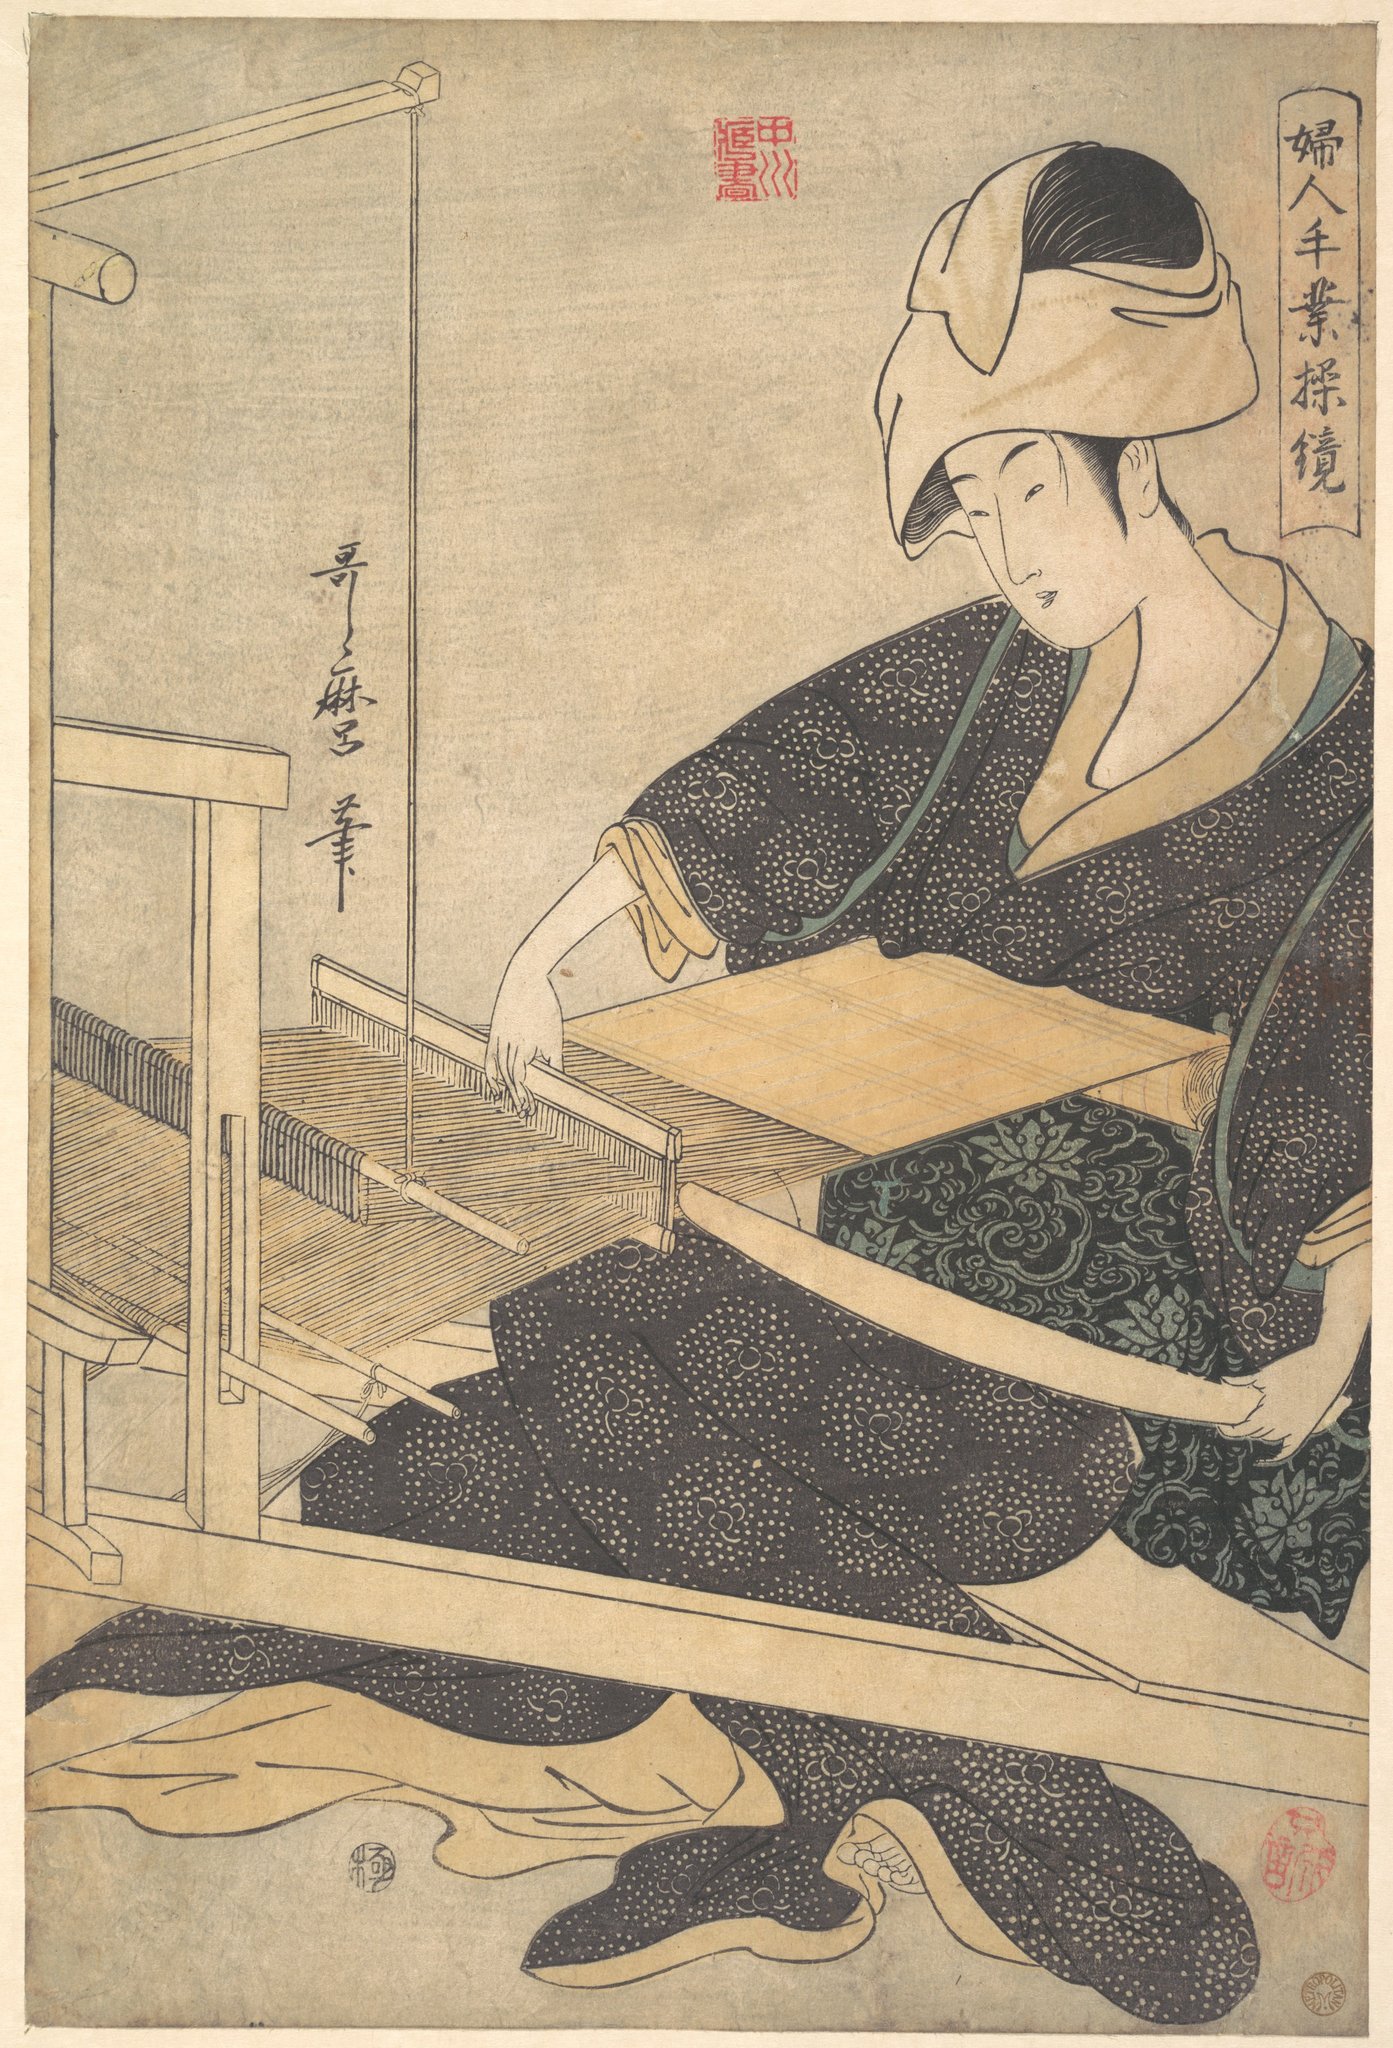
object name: woodblock print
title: A Woman Weaving, Seated at a Hand Loom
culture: japanese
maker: kitagawa utamaro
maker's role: artist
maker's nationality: japanese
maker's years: 1754-1806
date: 1796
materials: ink, paper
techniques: woodblock print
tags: women,looms